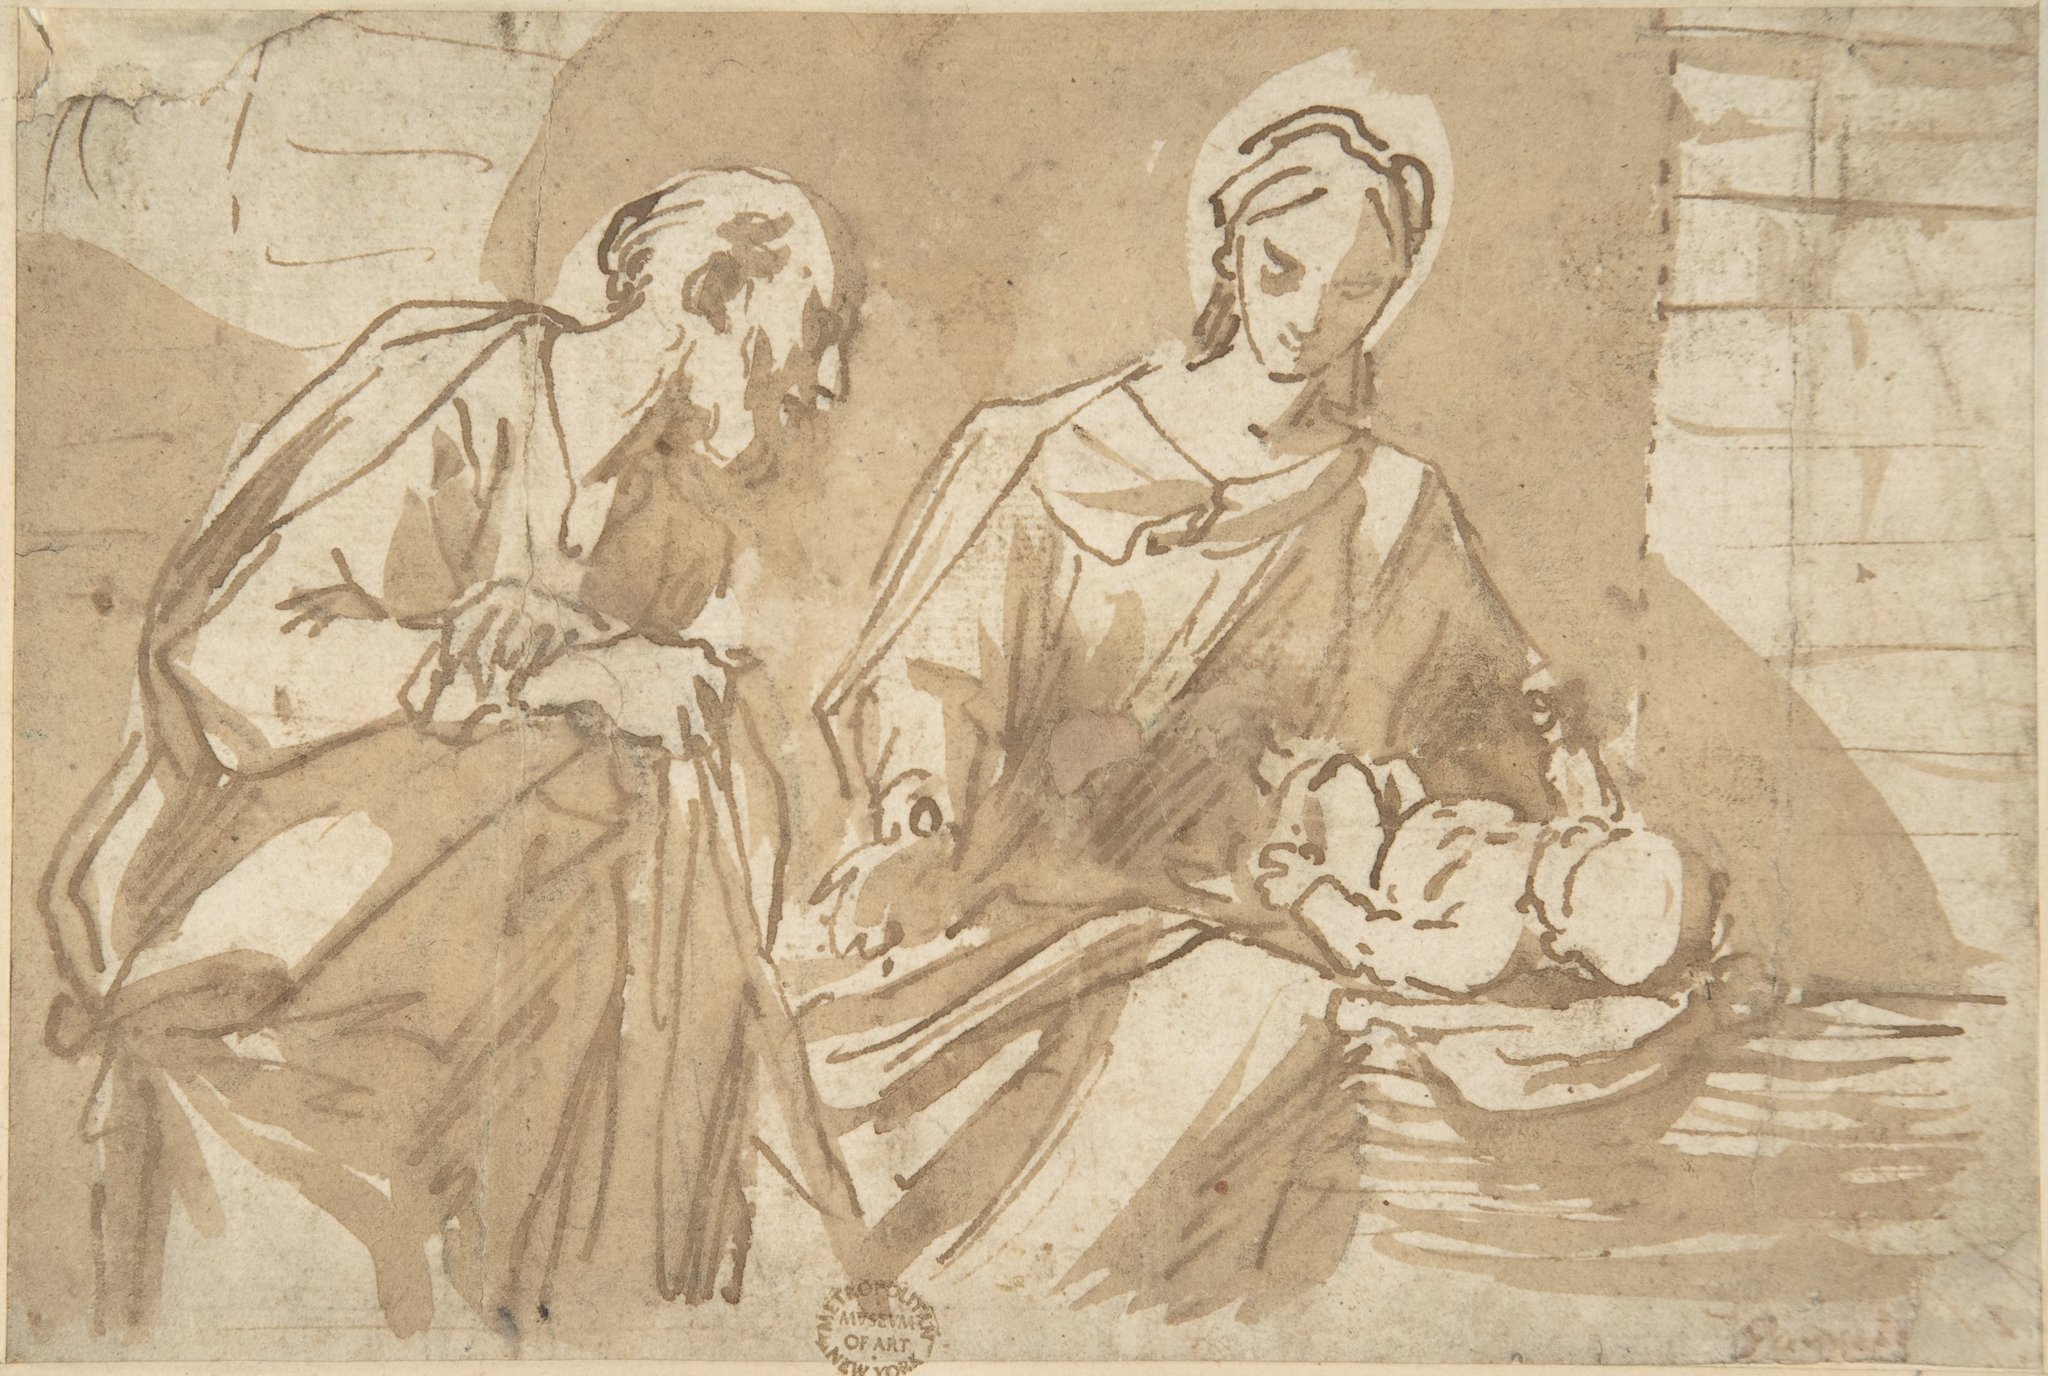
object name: drawing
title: Holy Family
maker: anonymous, italian, roman-bolognese, 17th century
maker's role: artist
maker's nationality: italian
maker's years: 1600-1700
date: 1601-1700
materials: charcoal, ink, paper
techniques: brush, pen, wash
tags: holy family